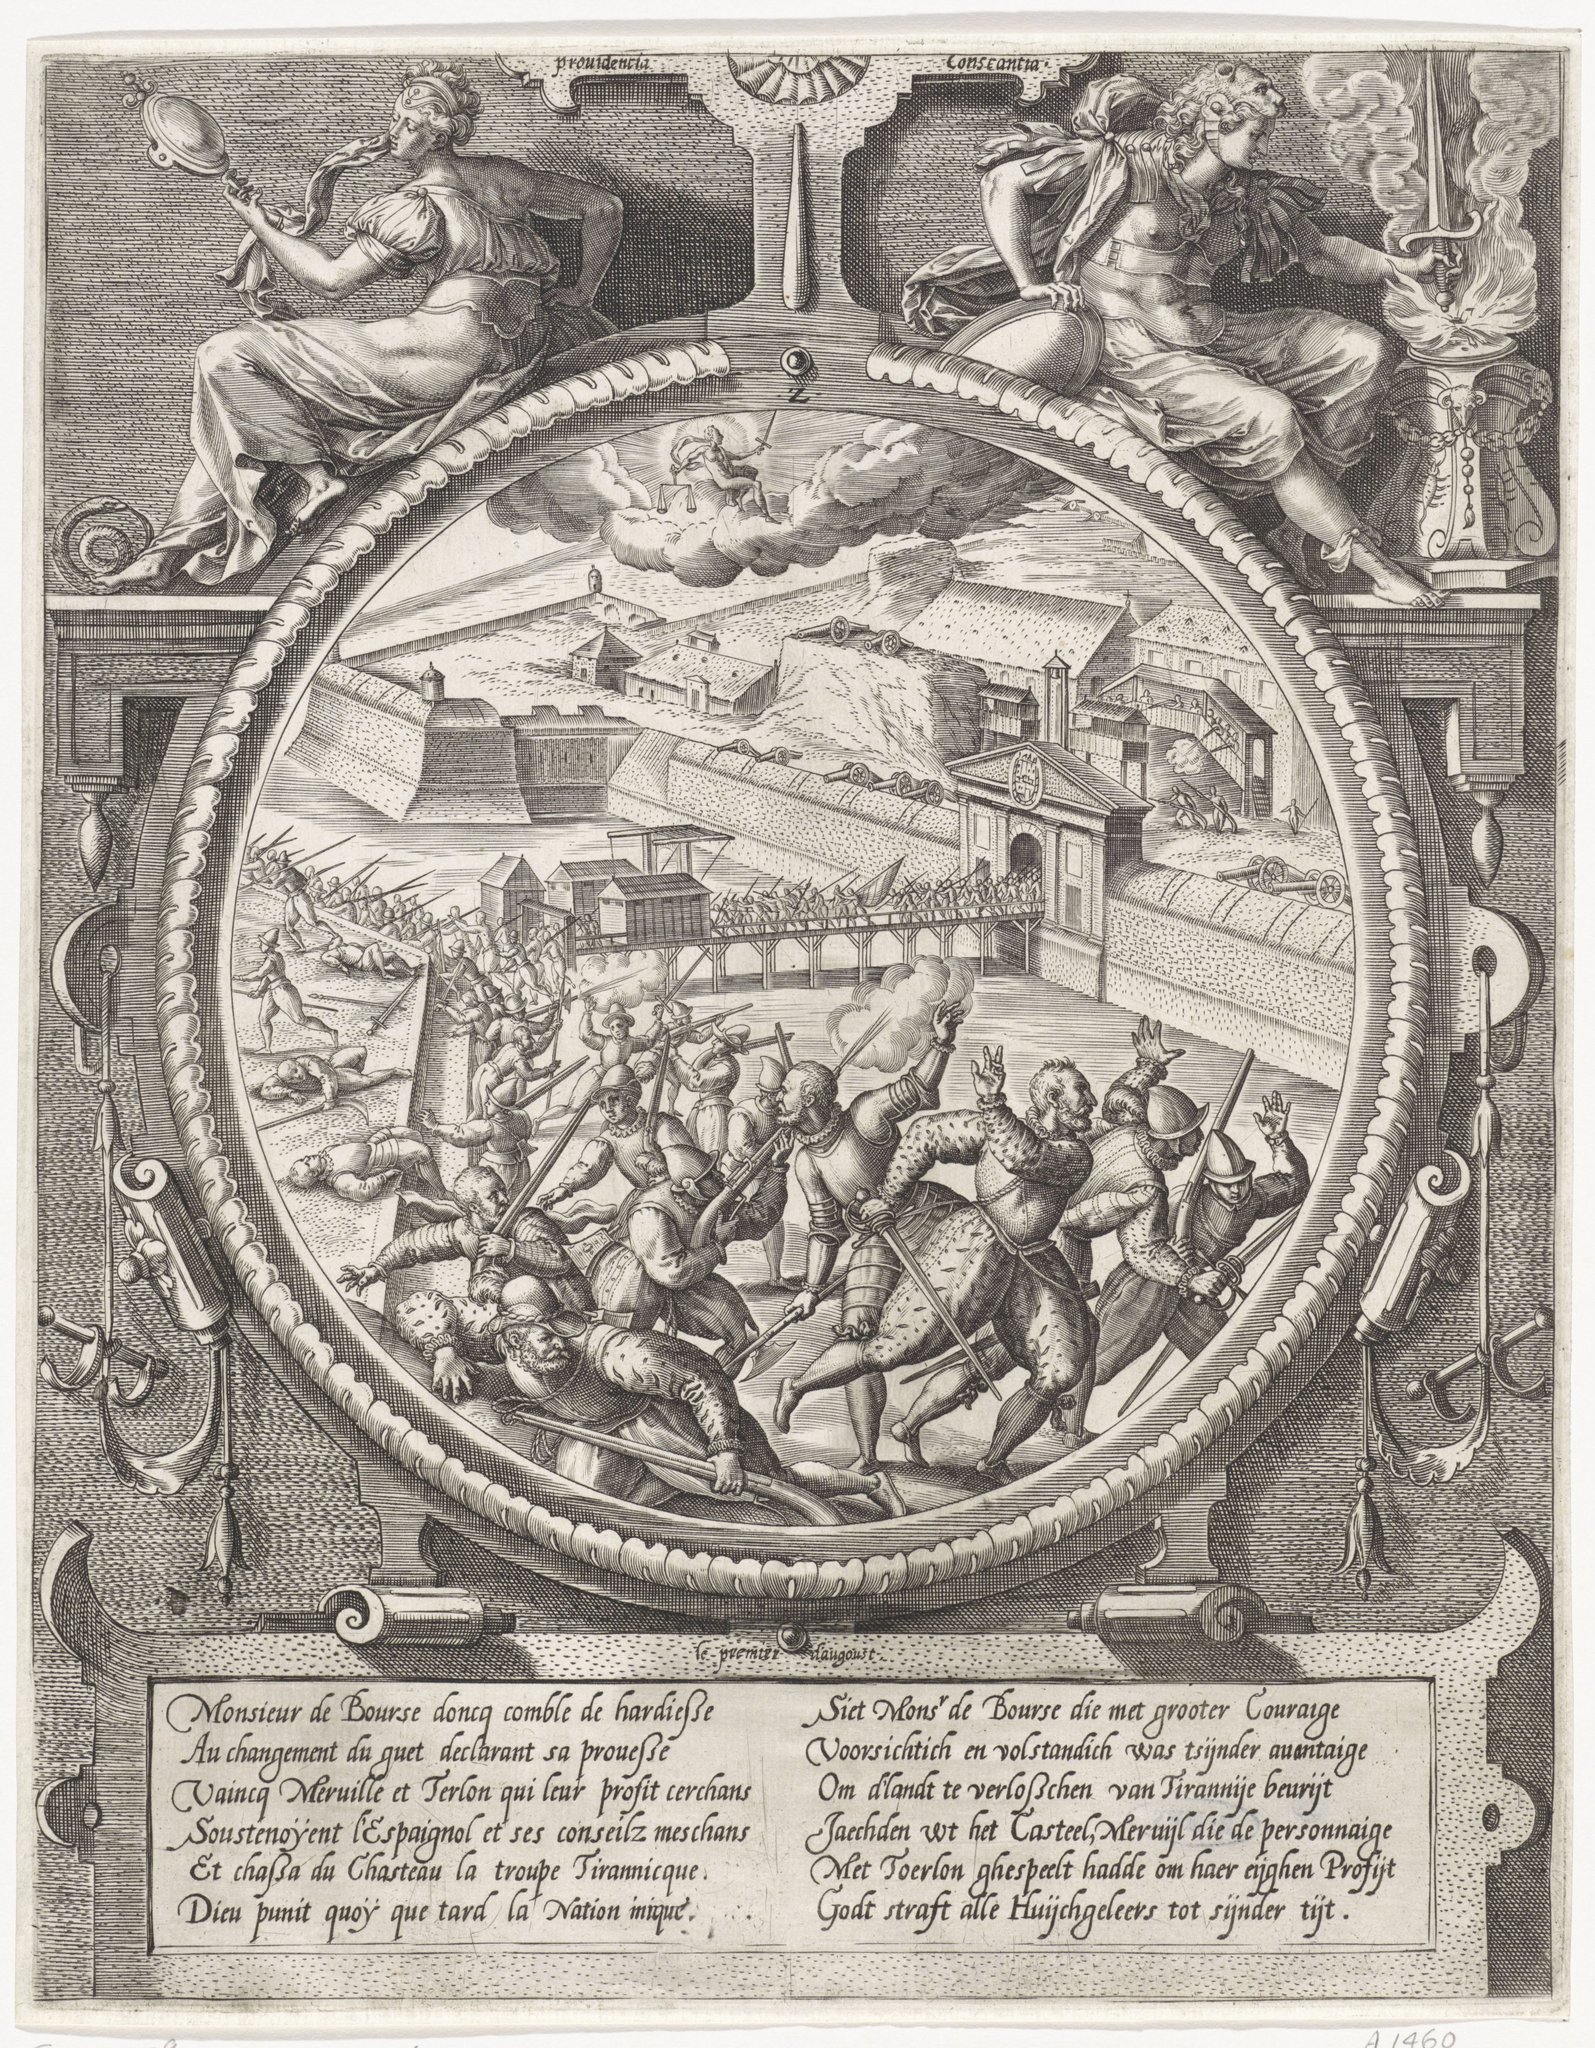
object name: print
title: De troepen van Bourse verdrijven de Duitse soldaten van Treslong en Merville uit de citadel, 1577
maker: wierix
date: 1578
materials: paper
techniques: engraving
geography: antwerp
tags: justice, 'justitia'; 'giustitia divina' (ripa) ~ one of the four cardinal virtues, capture of city (after the siege), forethought, deliberation; 'previdenza', 'providenza' (ripa), constancy, tenacity; 'costanza', 'tenacità' (ripa)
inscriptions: collector's mark: Lugt 2228, collector's mark: Lugt 2760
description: De troepen van Bourse verdrijven de Duitse soldaten van Treslong en Merville uit de citadel, 1 augustus 1577. In de wolken Gerechtigheid. Voorstelling in een rond medaillon met ornamentele allegorische omlijsting met bovenaan de zittende vrouwelijke personificaties van Voorzienigheid (Providentia) en Standvastigheid (Constantia). Onderaan een cartouche met 2 verzen van elk 6 regels in het Frans en Nederlands.